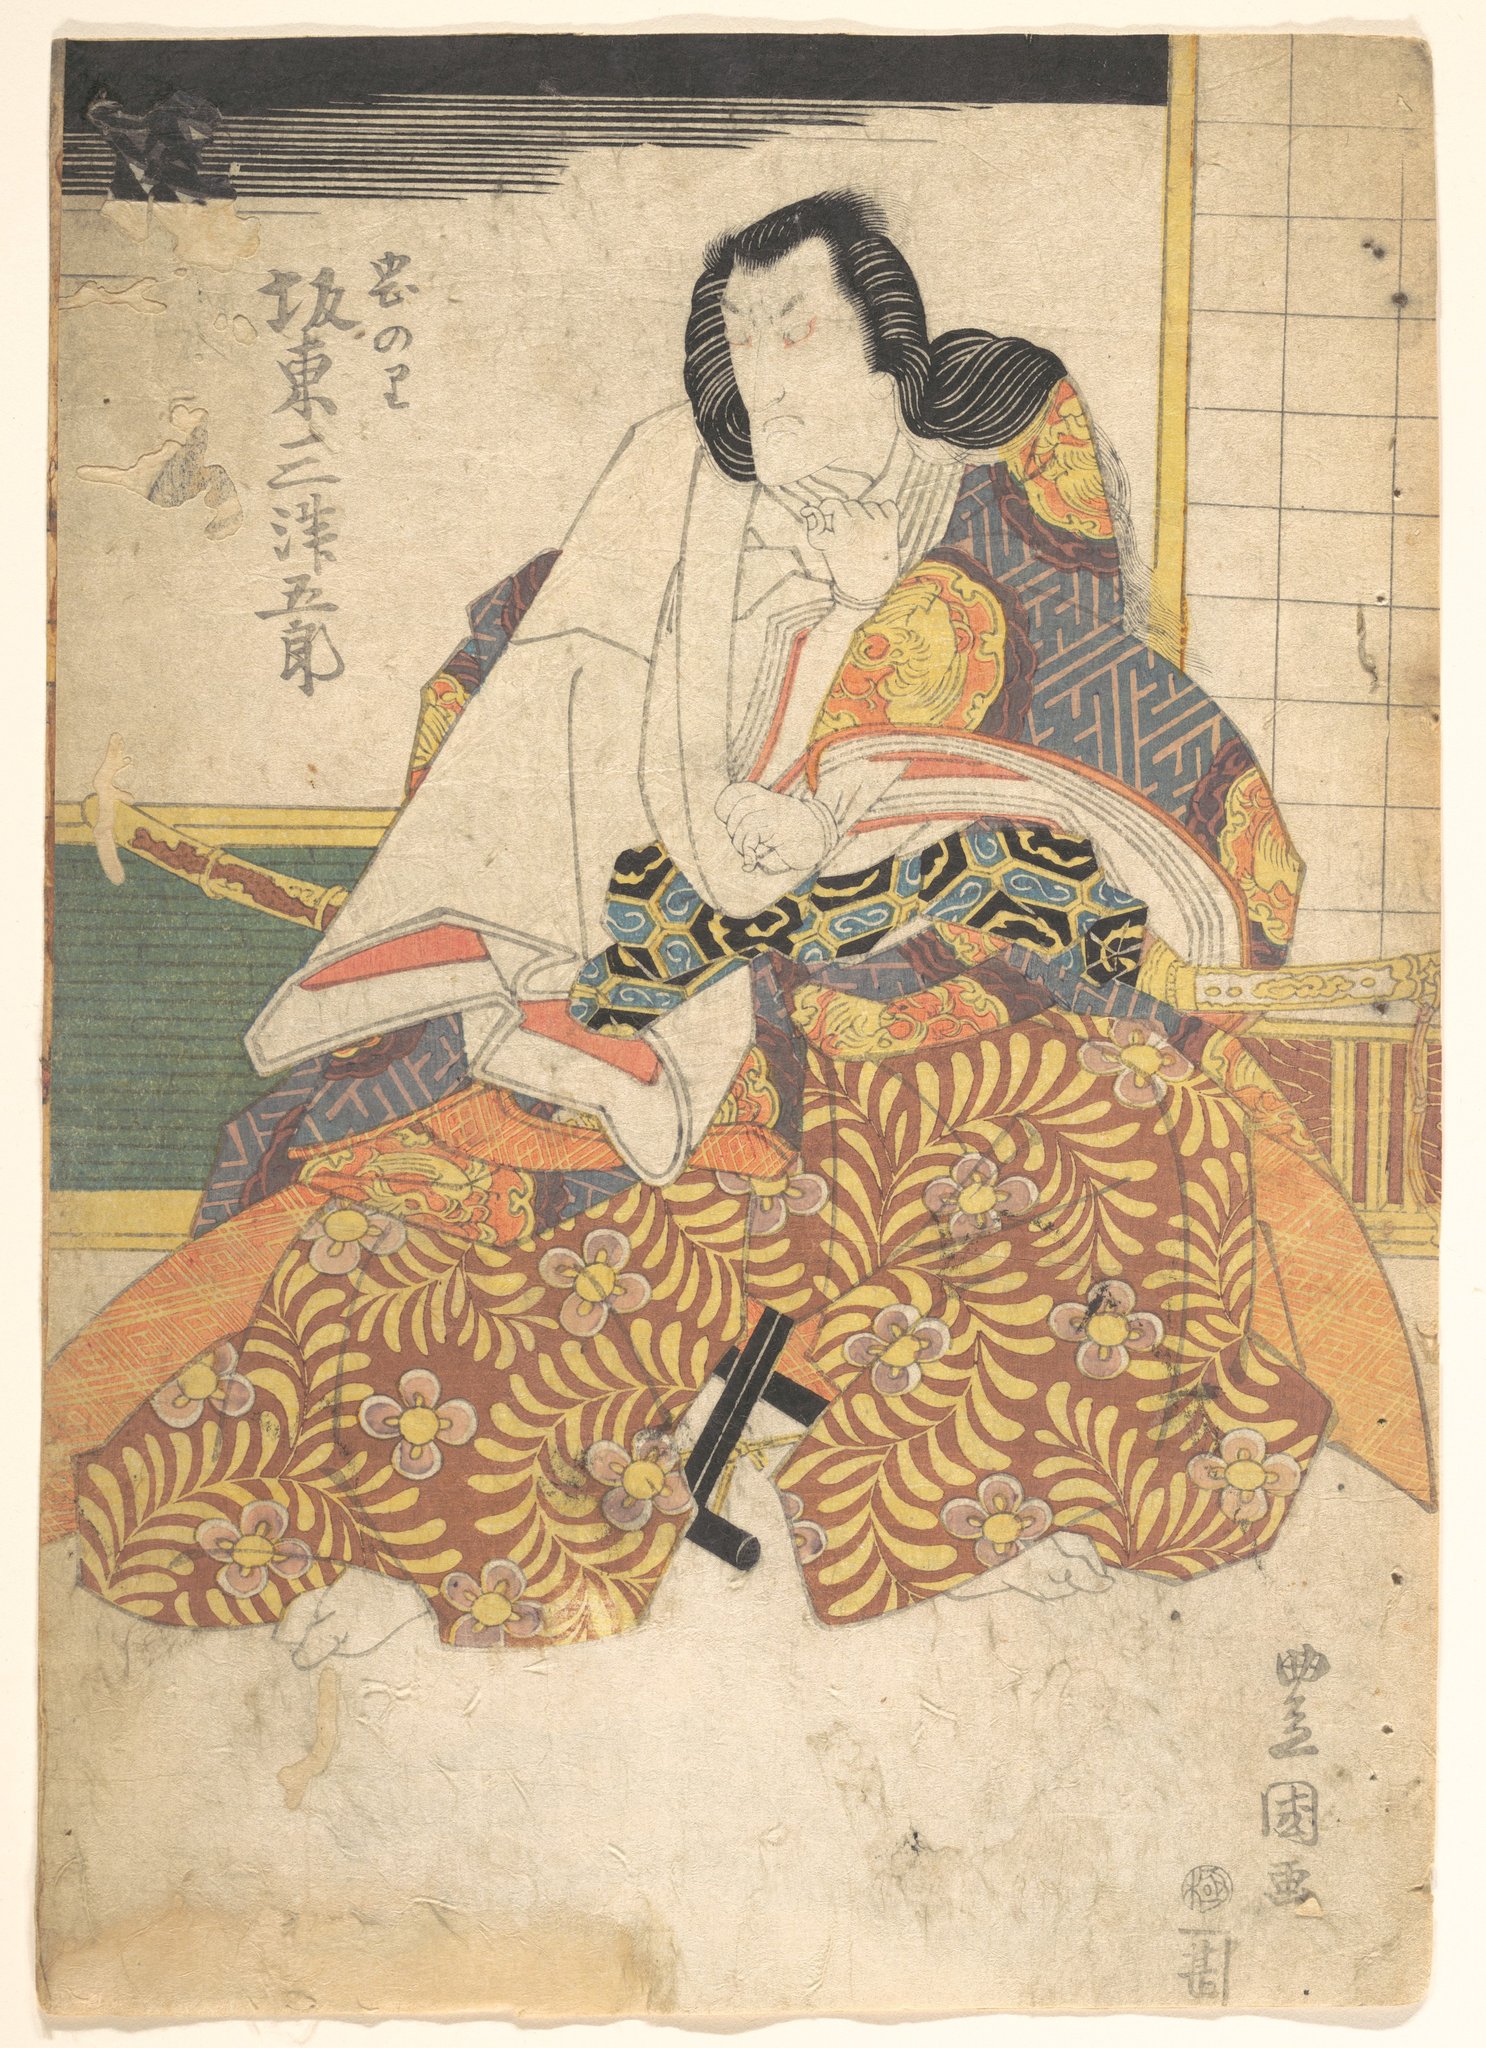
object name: print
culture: japanese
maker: utagawa kunisada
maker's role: artist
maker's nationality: japanese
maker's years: 1786-1864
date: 1801-1900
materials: ink, paper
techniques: woodblock print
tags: men